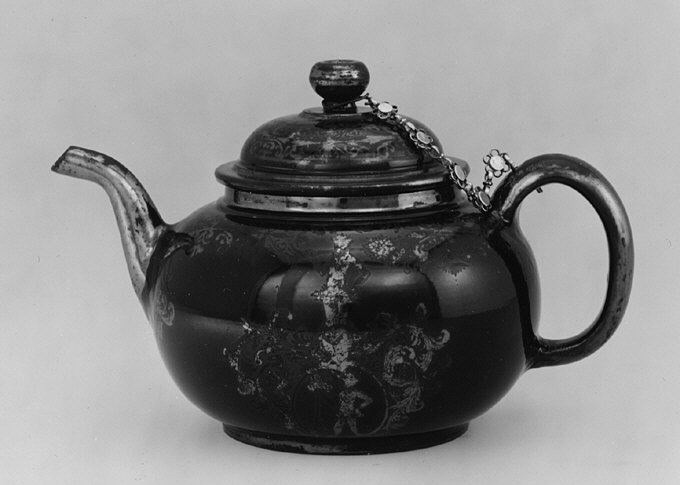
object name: teapot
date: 1735-1750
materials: earthenware